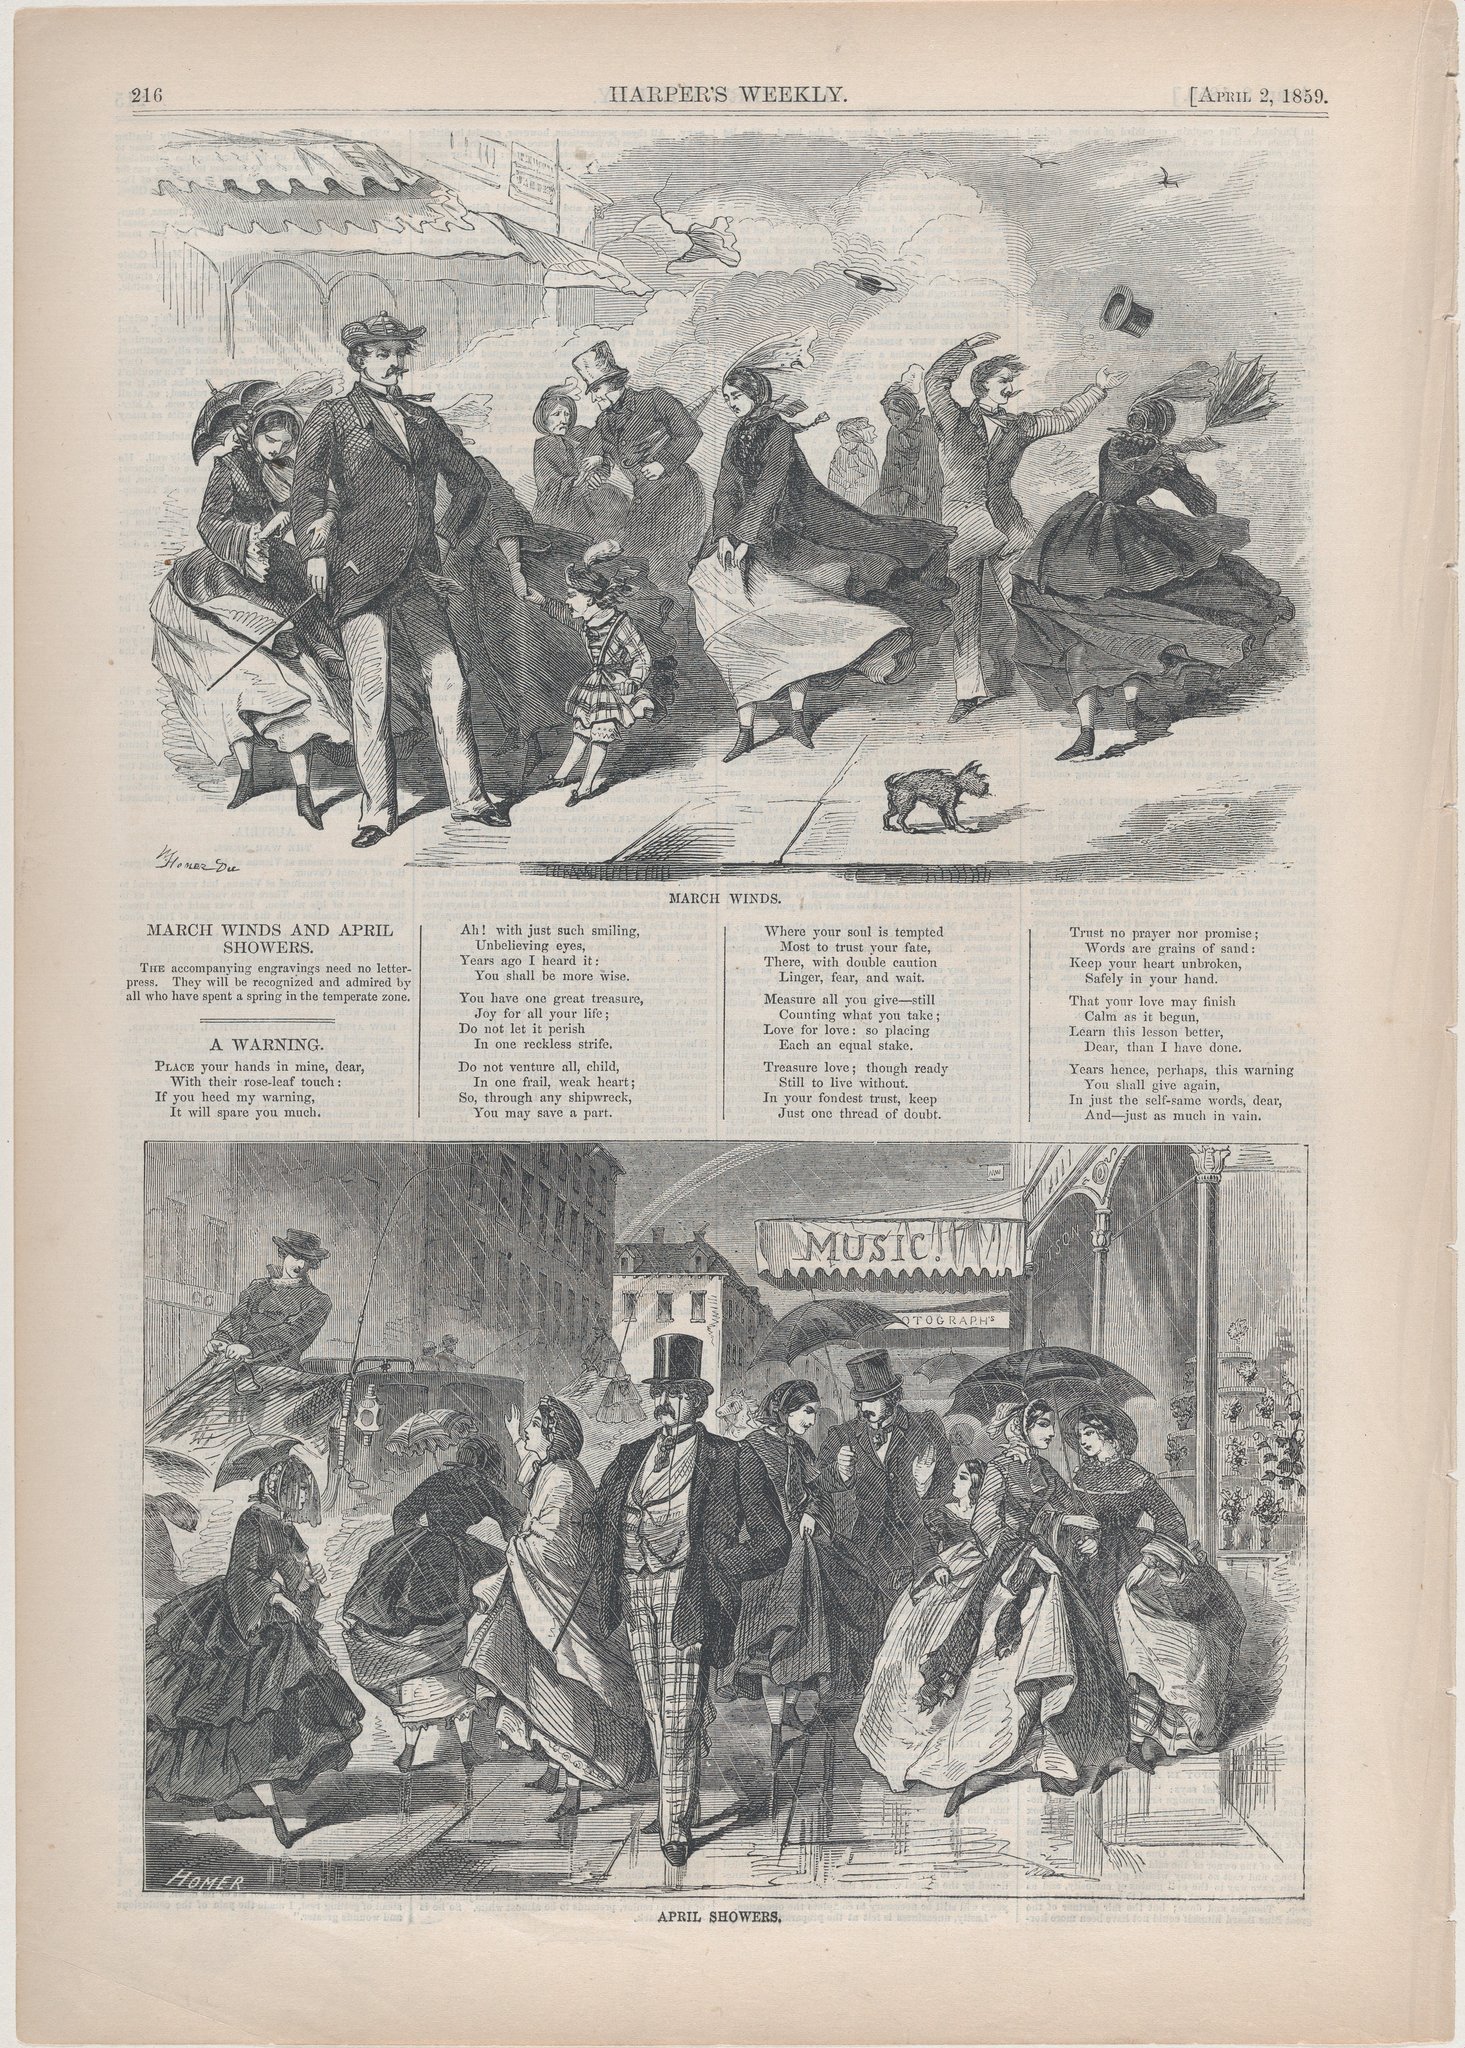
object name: print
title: April Showers (from "Harper's Weekly," Vol. III)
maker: winslow homer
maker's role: artist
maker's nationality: american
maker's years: 1836-1910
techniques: engraving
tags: men,women,rain,wind